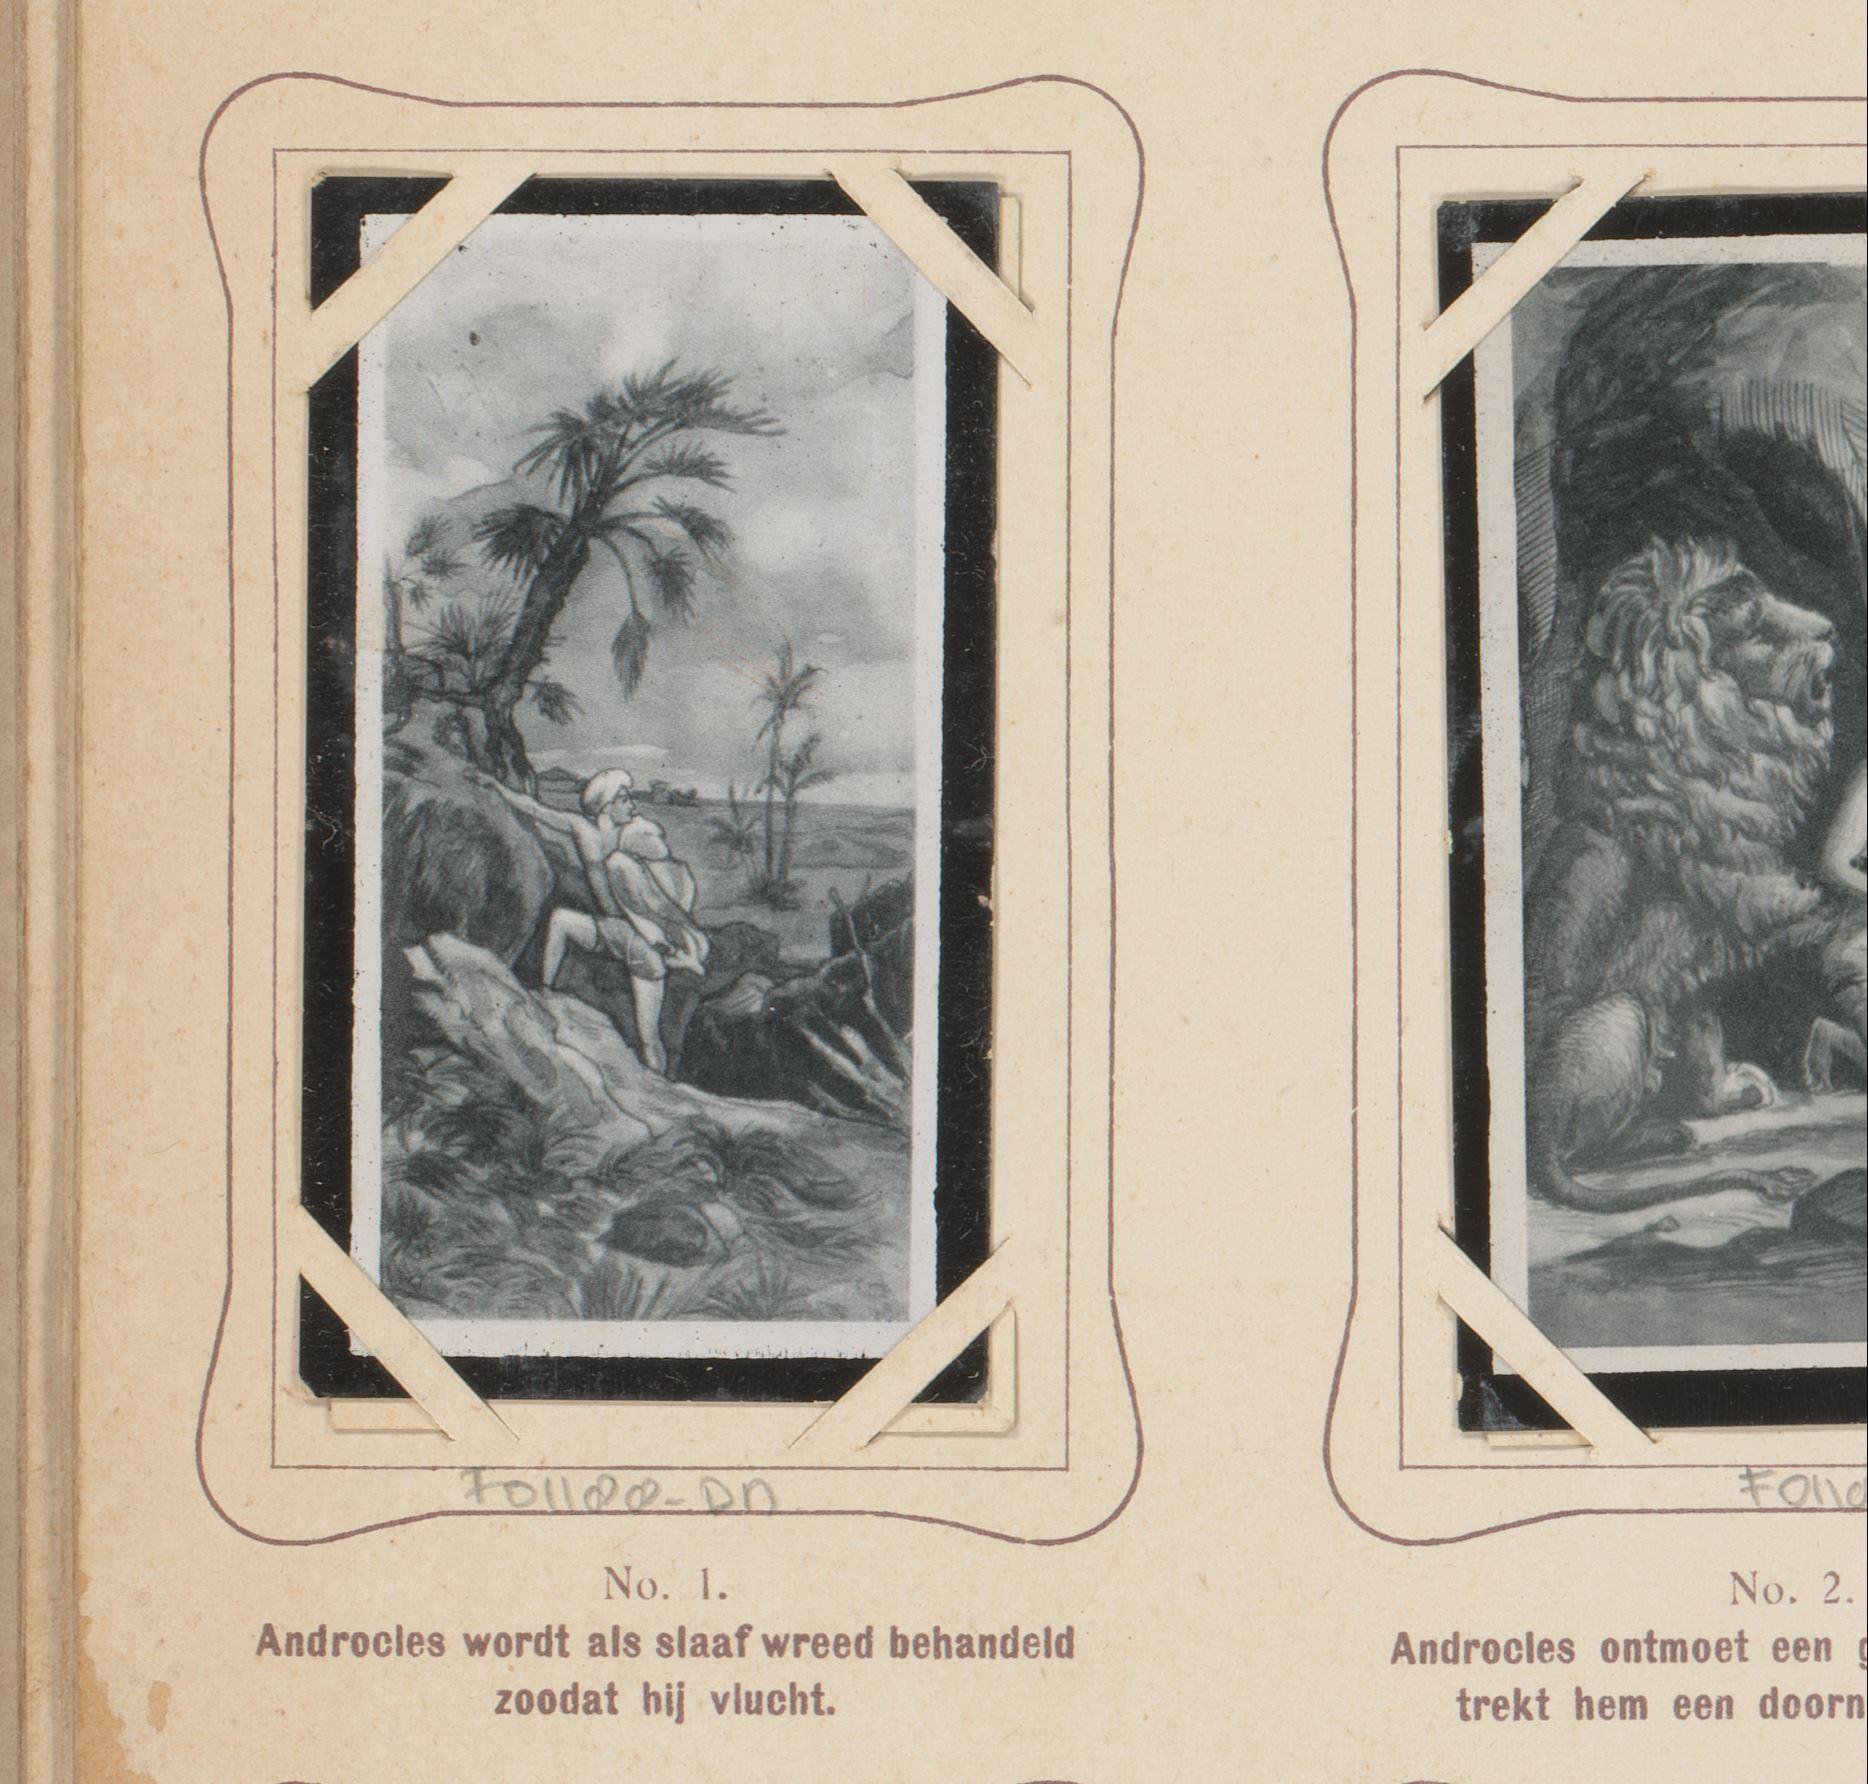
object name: reproduction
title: Reproductie van een tekening van een vluchtende Androclus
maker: Anonymous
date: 1906-1907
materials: paper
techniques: photograph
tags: (story of) androclus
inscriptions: inscription: ‘No. 1./ Androcles wordt als slaaf wreed behandeld zodat hij vlucht.’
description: Deze prent maakt deel uit van een album.